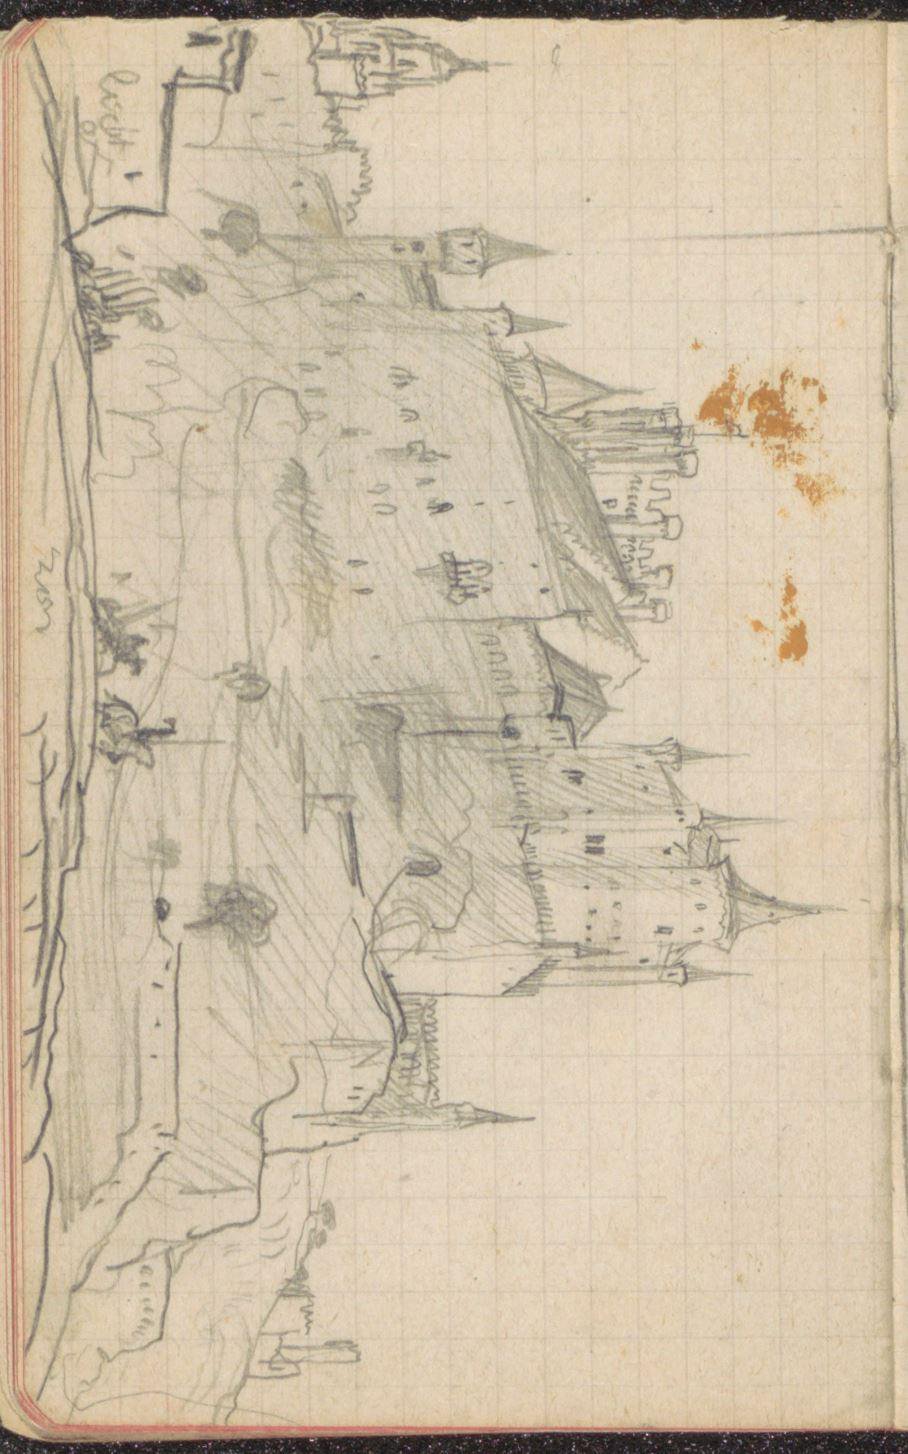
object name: sketchbook leaf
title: Kasteel van Segovia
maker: marius bauer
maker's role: draughtsman, print maker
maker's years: 1867-1932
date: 1902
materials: pencil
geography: segovia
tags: castle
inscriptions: kleurnotitie, handgeschreven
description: Pagina 18 uit een schetsboek met 23 bladen.